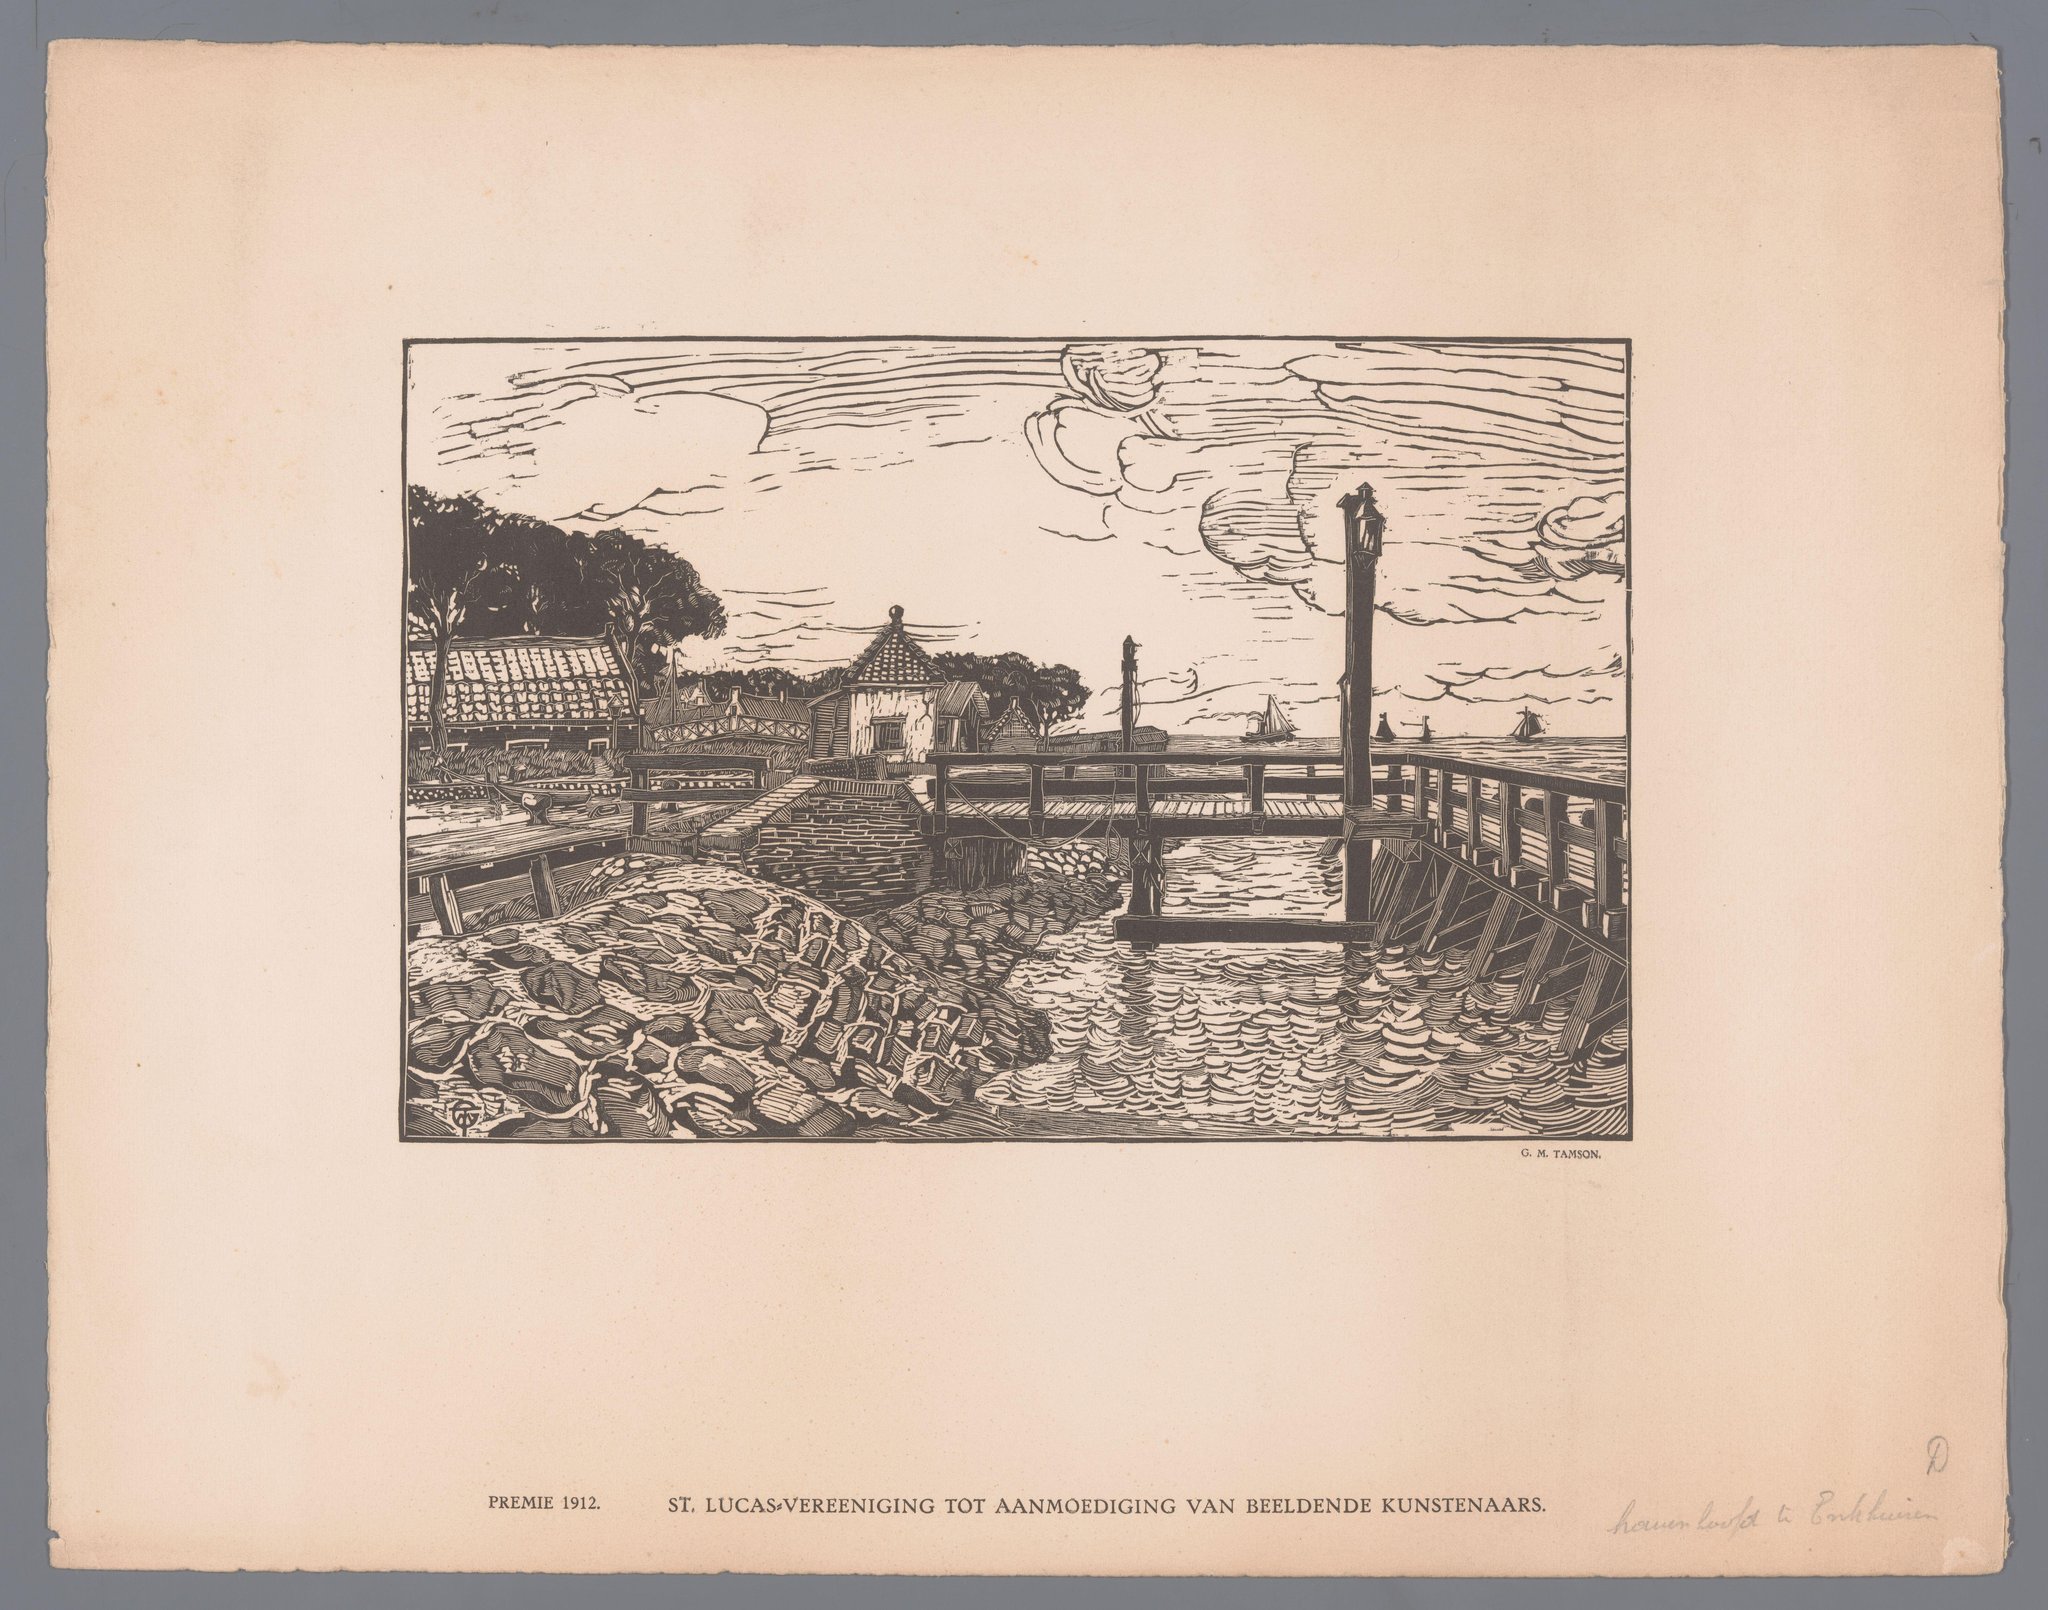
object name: print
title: Gezicht op steiger en huizen in de haven van Enkhuizen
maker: george marinus tamson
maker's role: print maker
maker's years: 1873-1939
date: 1912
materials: paper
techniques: woodcut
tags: harbour, housing, traffic on the water, enkhuizen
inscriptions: collector's mark: Lugt 2233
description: Op blad vermeld: Premie 1912. St. Lucas-vereeniging tot aanmoediging van beeldende kunstenaars.